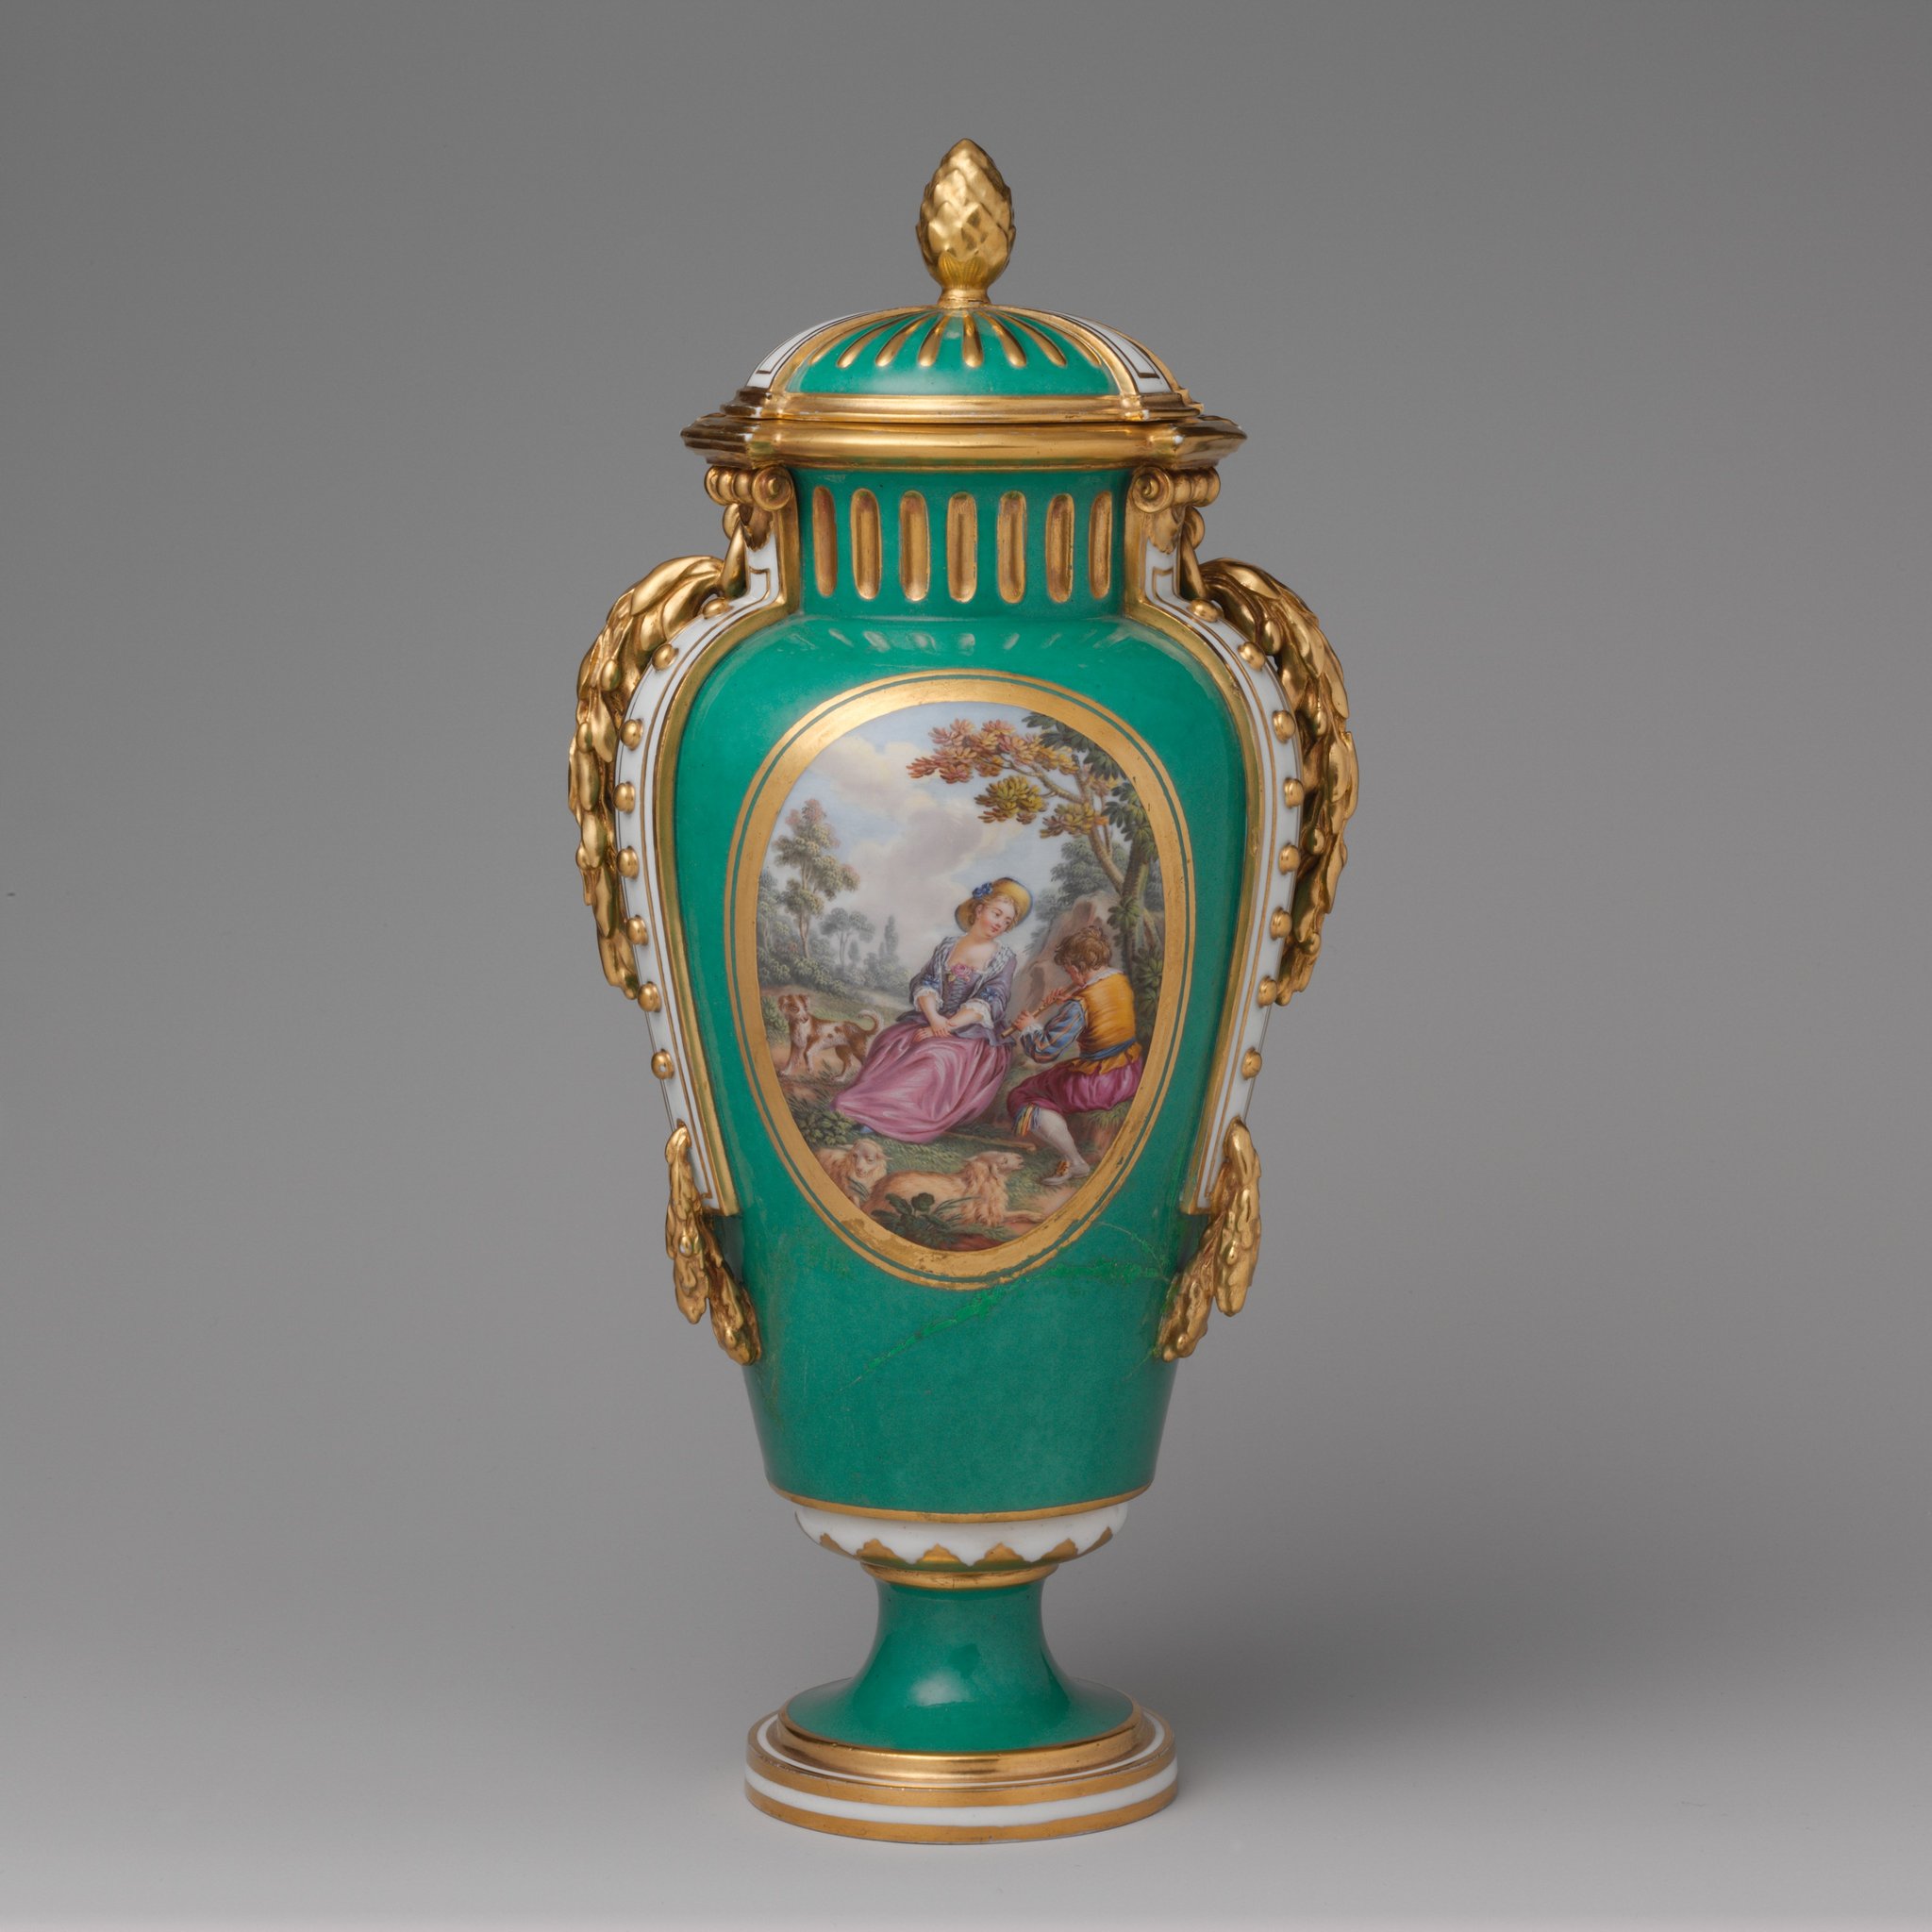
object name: vase with cover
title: Vase with cover (vase à bandes) (one of a pair)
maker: sèvres manufactory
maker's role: manufactory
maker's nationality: french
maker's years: 1740-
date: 1770-1775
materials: soft paste porcelain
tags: boys,women,flutes